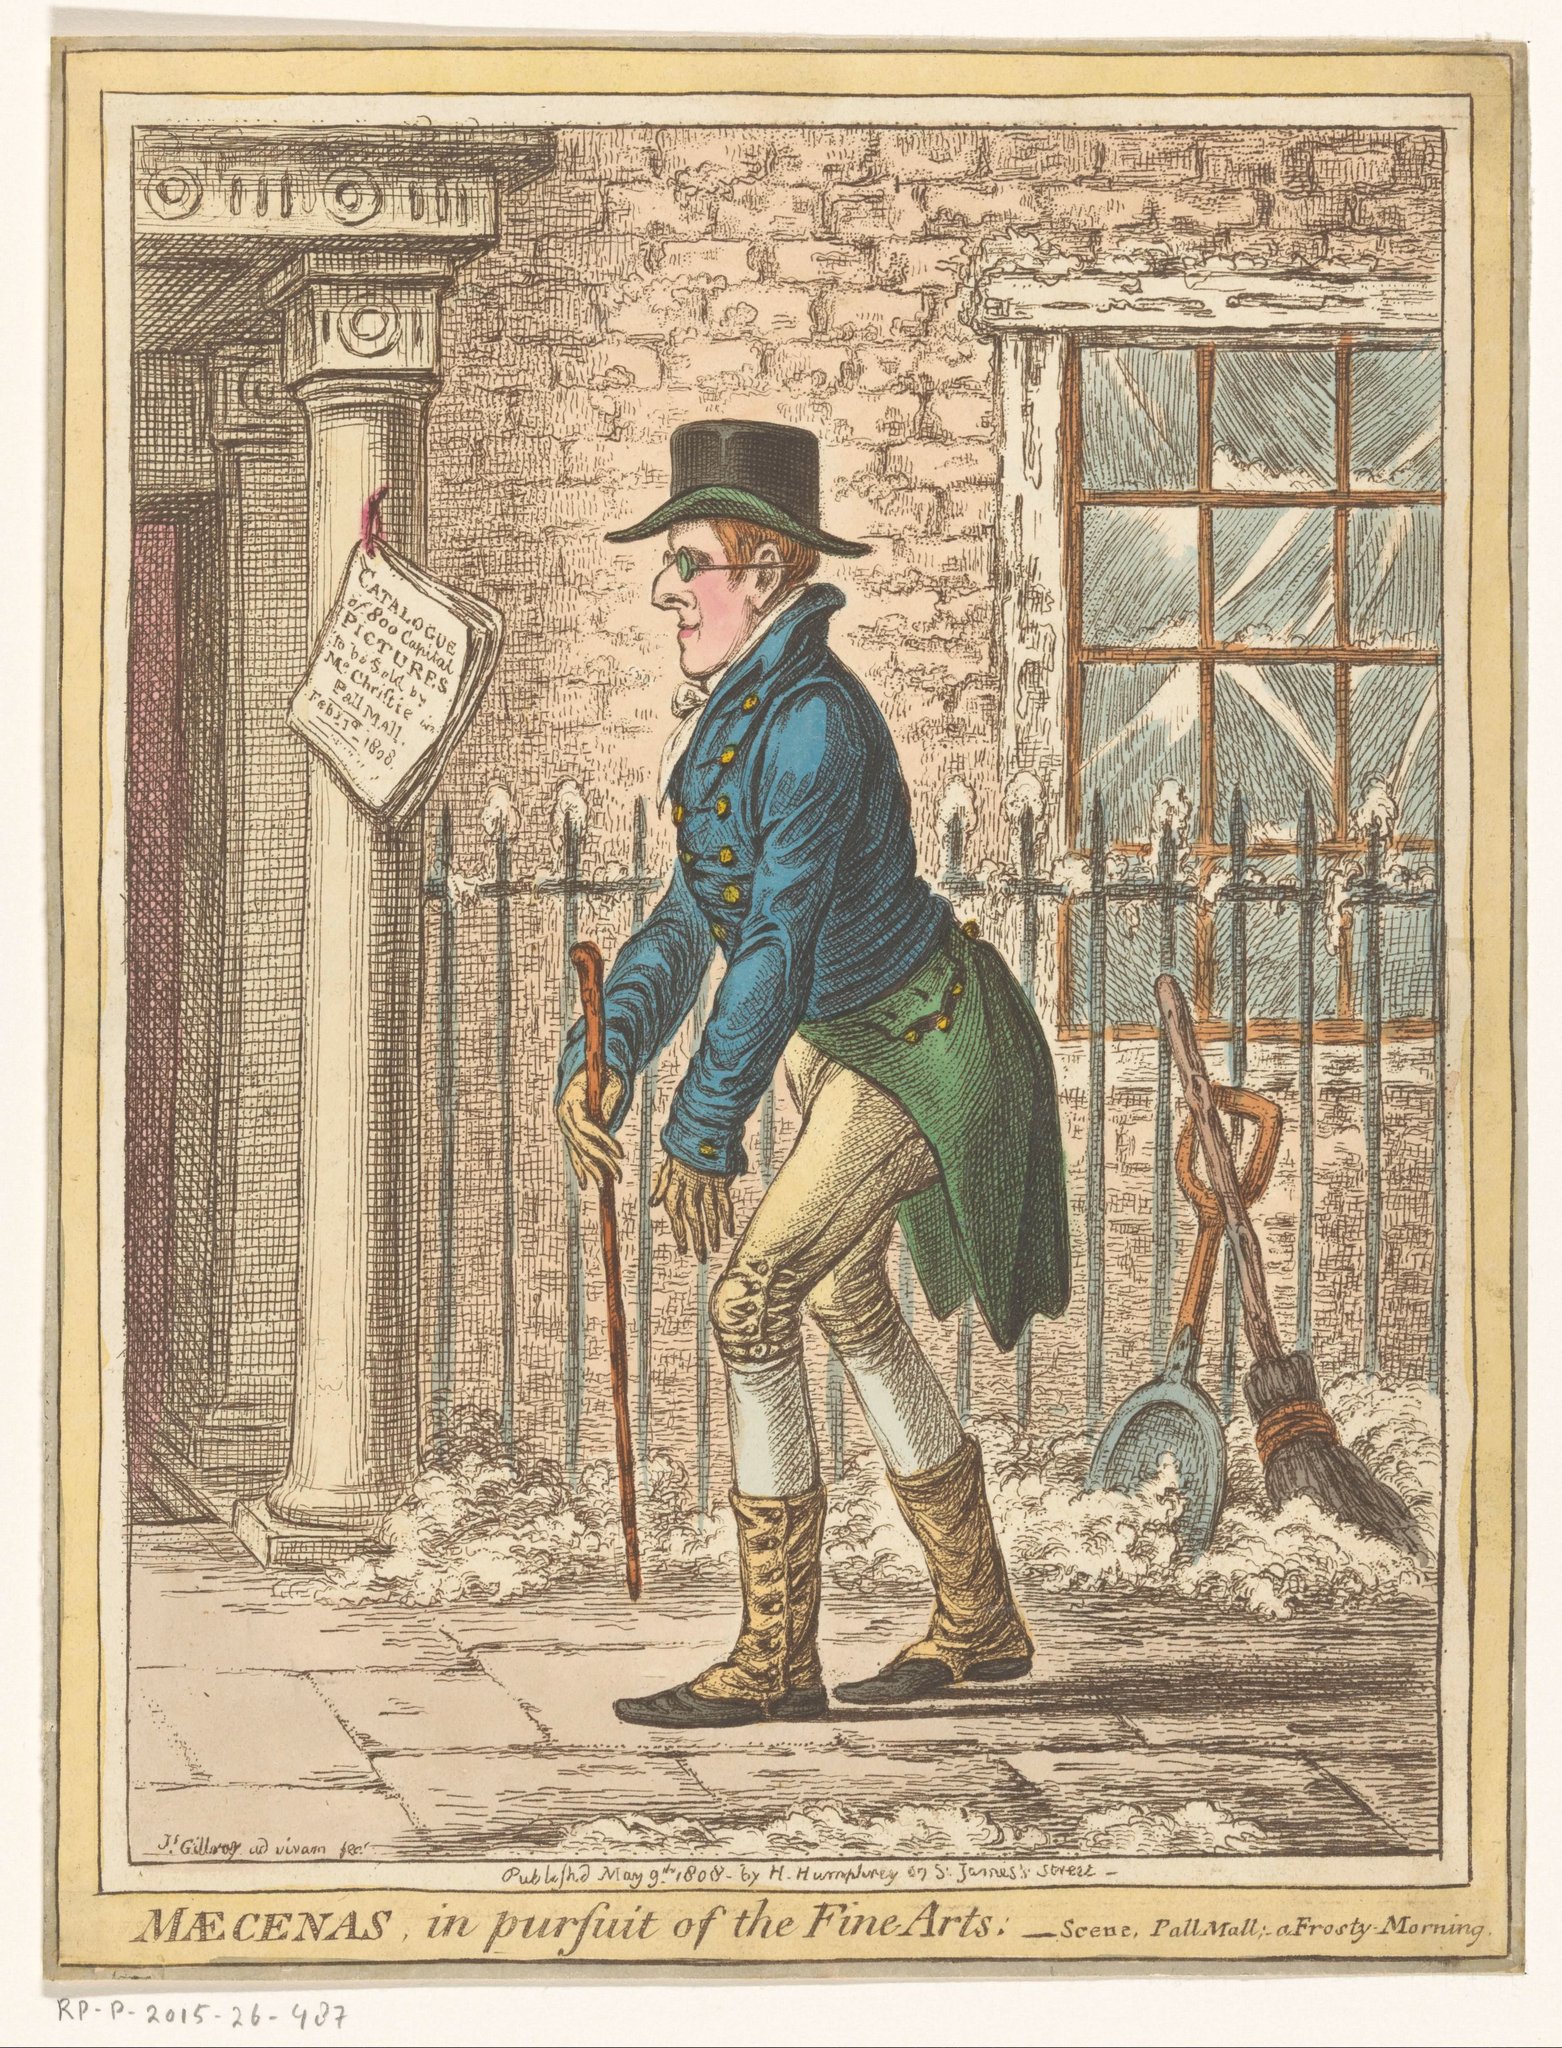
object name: print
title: Kunstverzamelaar voor de ingang van Christie's, Pall Mall Londen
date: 1805-1808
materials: paper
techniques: etching, hand coloring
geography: london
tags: art collecting, art sale, auction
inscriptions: collector's mark: Lugt 4779, collector's mark: Lugt 2228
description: Een man met een wandelstok en een bril loopt langs de ingang van Christie's waar aan een pilaar een aankondiging van een schilderijenveiling hangt. Het trottoir is schoongeveegd van sneeuw, tegen het hek staan een sneeuwschep en een bezem.